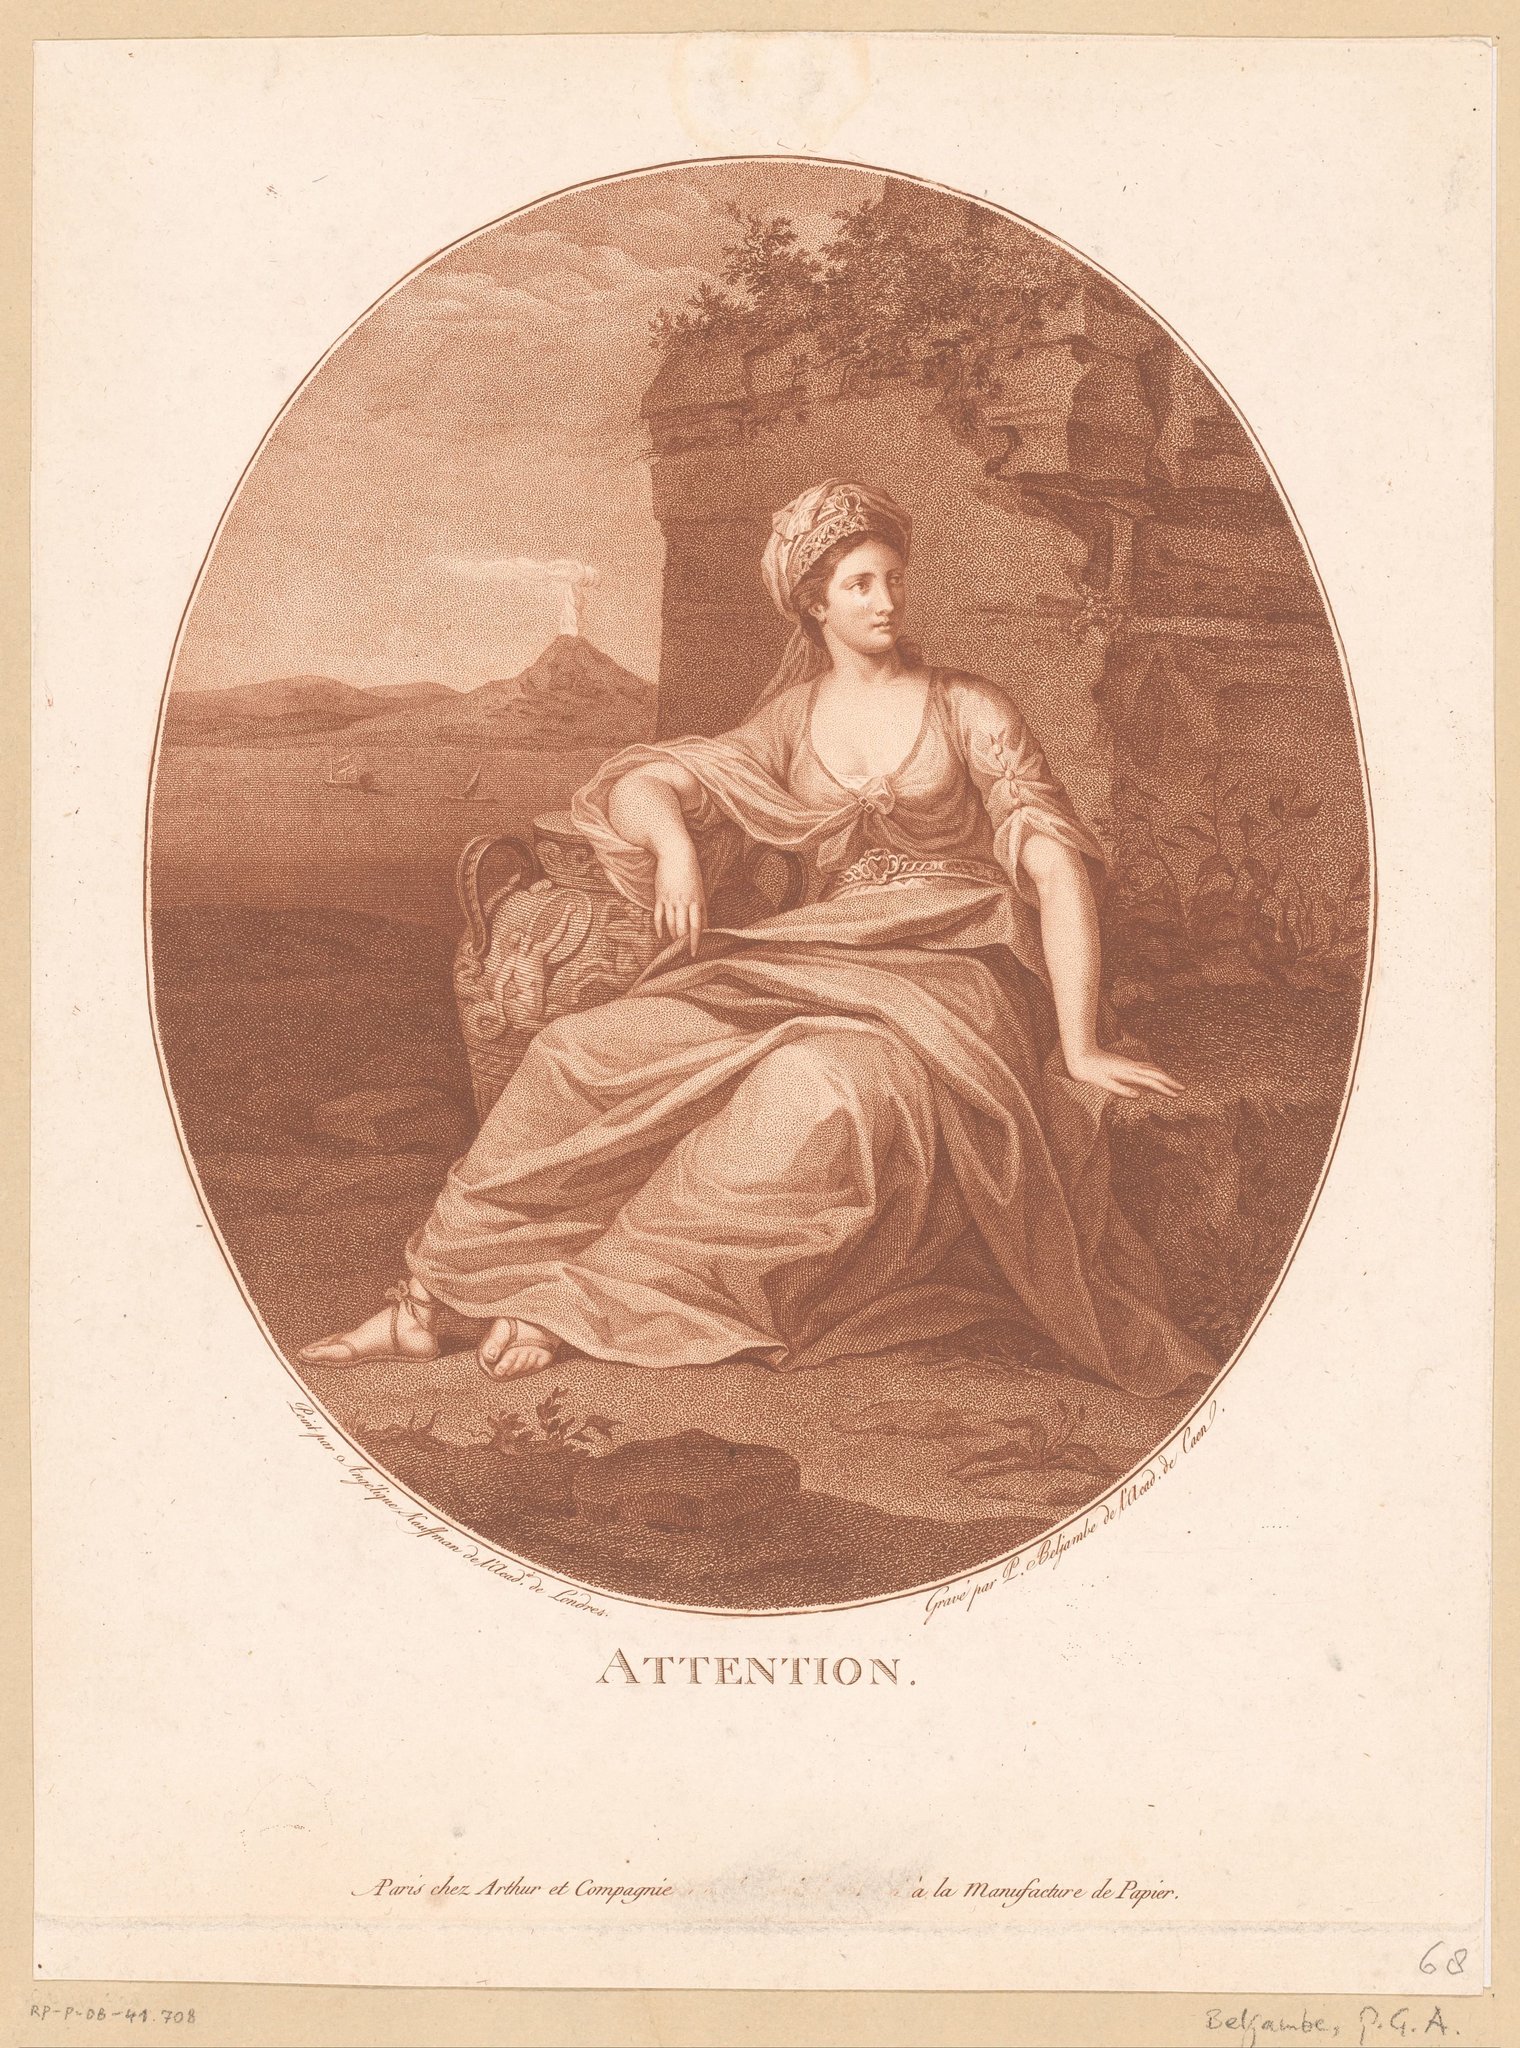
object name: print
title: Attention.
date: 1769-1820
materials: paper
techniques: stippling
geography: paris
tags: landscapes, vase ~ ornament - aa - stylized, anonymous historical person portrayed alone - bb - woman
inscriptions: collector's mark: Lugt 2228